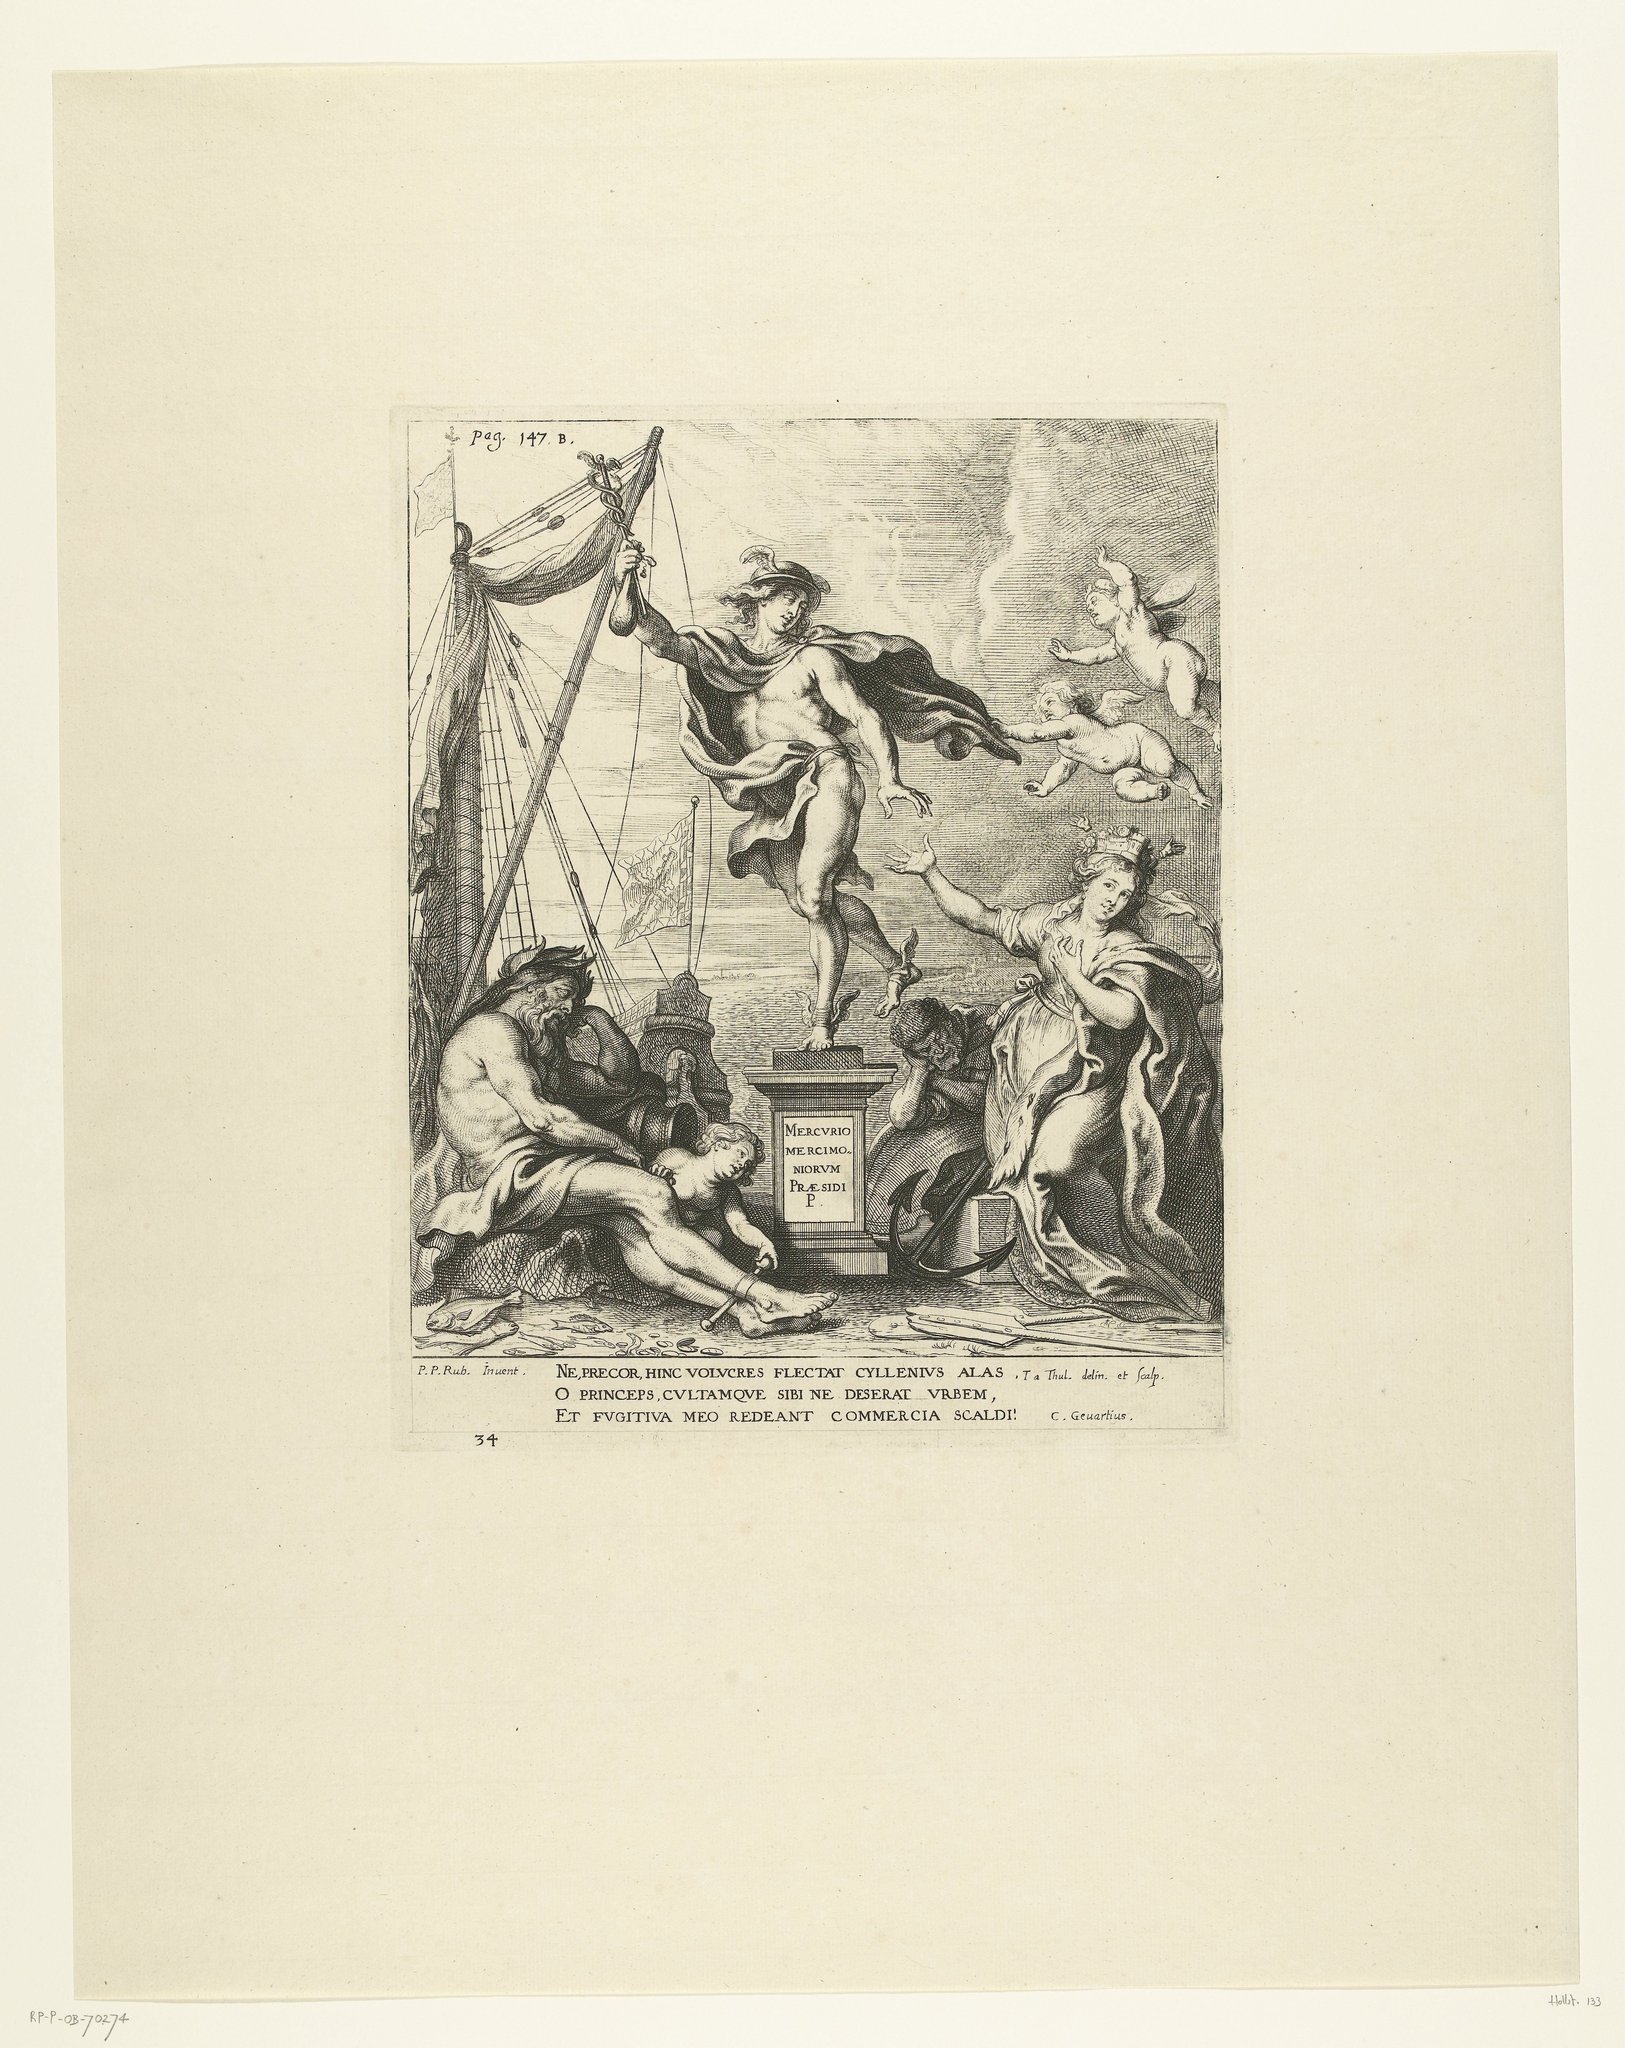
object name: print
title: Mercurius verlaat Antwerpen; intocht van Ferdinand te Antwerpen in 1635 (nr. 34)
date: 1639-1641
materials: paper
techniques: engraving, etching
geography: southern netherlands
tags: brussels, landvoogd der zuidelijke nederlanden ferdinand van oostenrijk, personification of a city, town-patron(ess), specific aspects, allegorical aspects of mercury; mercury as patron, other decorative structures (~ triumphal entry, etc.), antwerp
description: Mercurius verlaat Antwerpen. Door de oorlog en de afsluiting van de Schelde dreigt de handel in Antwerpen onder te gaan. Mercurius met links de slapende riviergod van de Schelde, rechts de stadsmaagd van Antwerpen. Met onderschrift van 3 regels in het Latijn. De centrale voorstelling op het toneel van Mercurius, opgesteld op de Sint-Jansbrug. Gemerkt linksboven: pag. 147B. Blad nr. 34 in een geheel van 43 platen die de uitgave van de beschrijving van de intocht van de Kardinaal Infant Ferdinand van Oostenrijk te Antwerpen op 17 april 1635 als de nieuwe landvoogd voor de Spaanse Nederlanden illustreren.